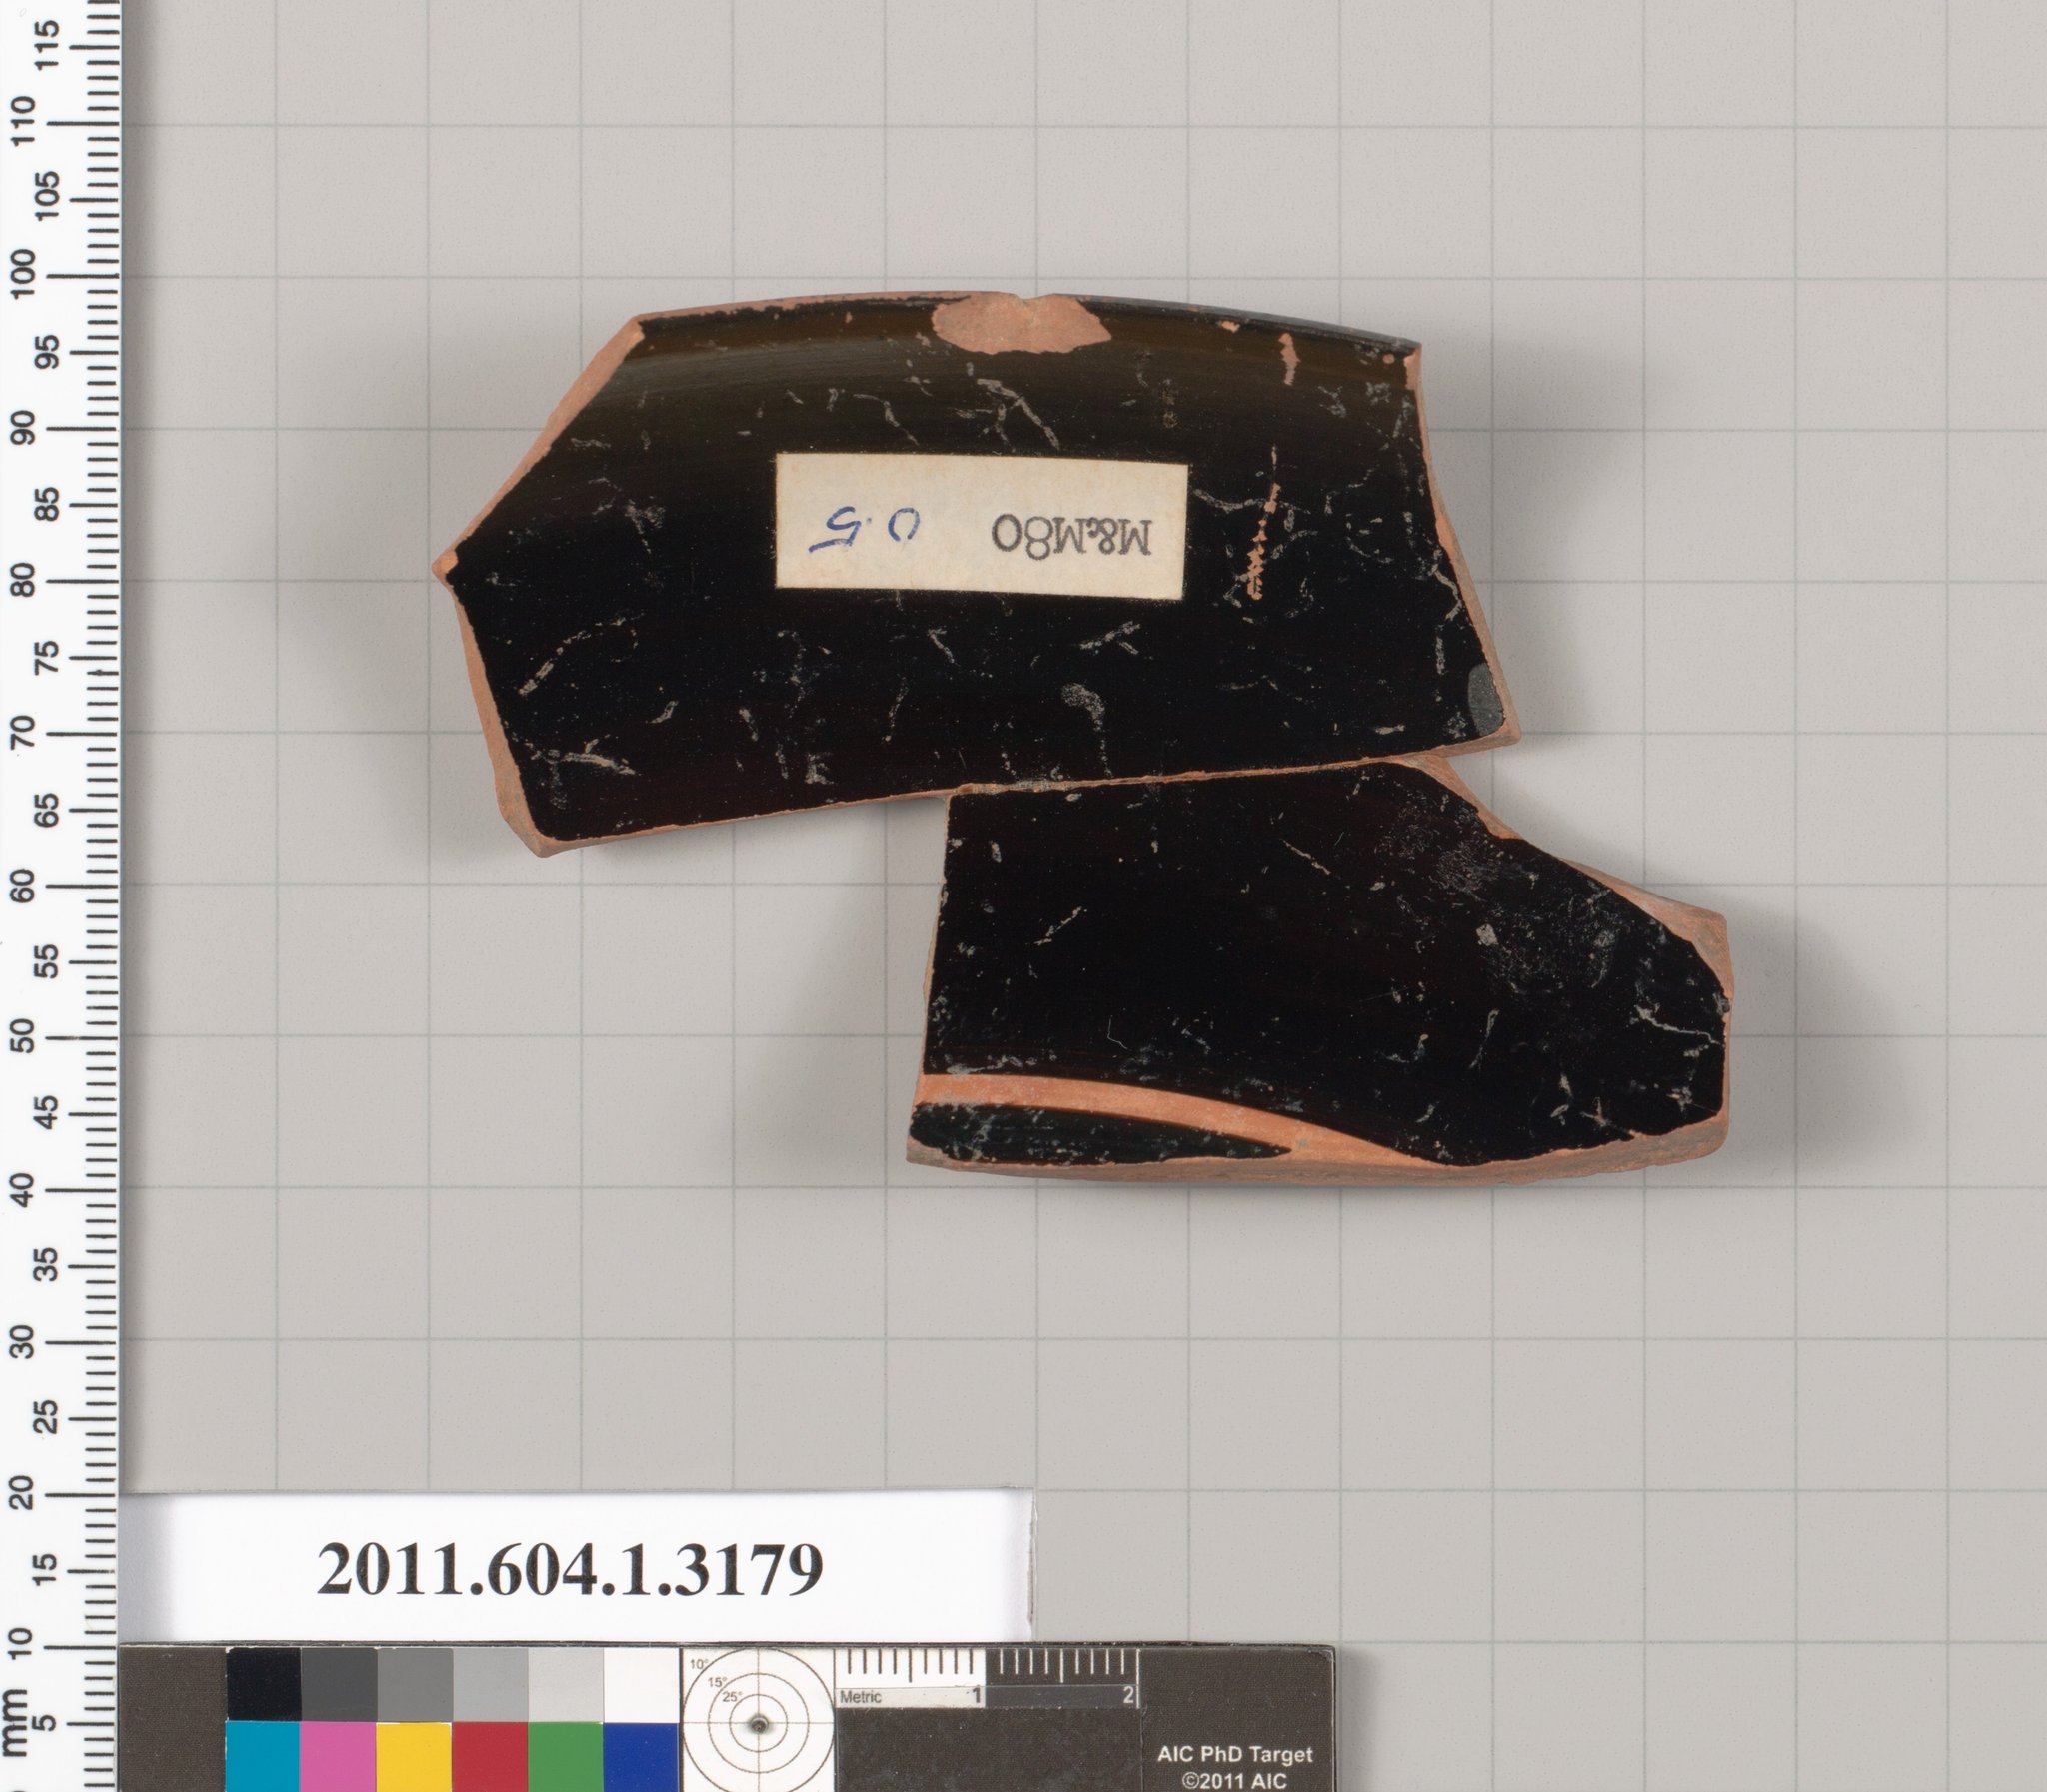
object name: kylix fragment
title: Terracotta fragment of a kylix (drinking cup)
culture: greek, attic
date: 475-451 BCE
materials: terracotta